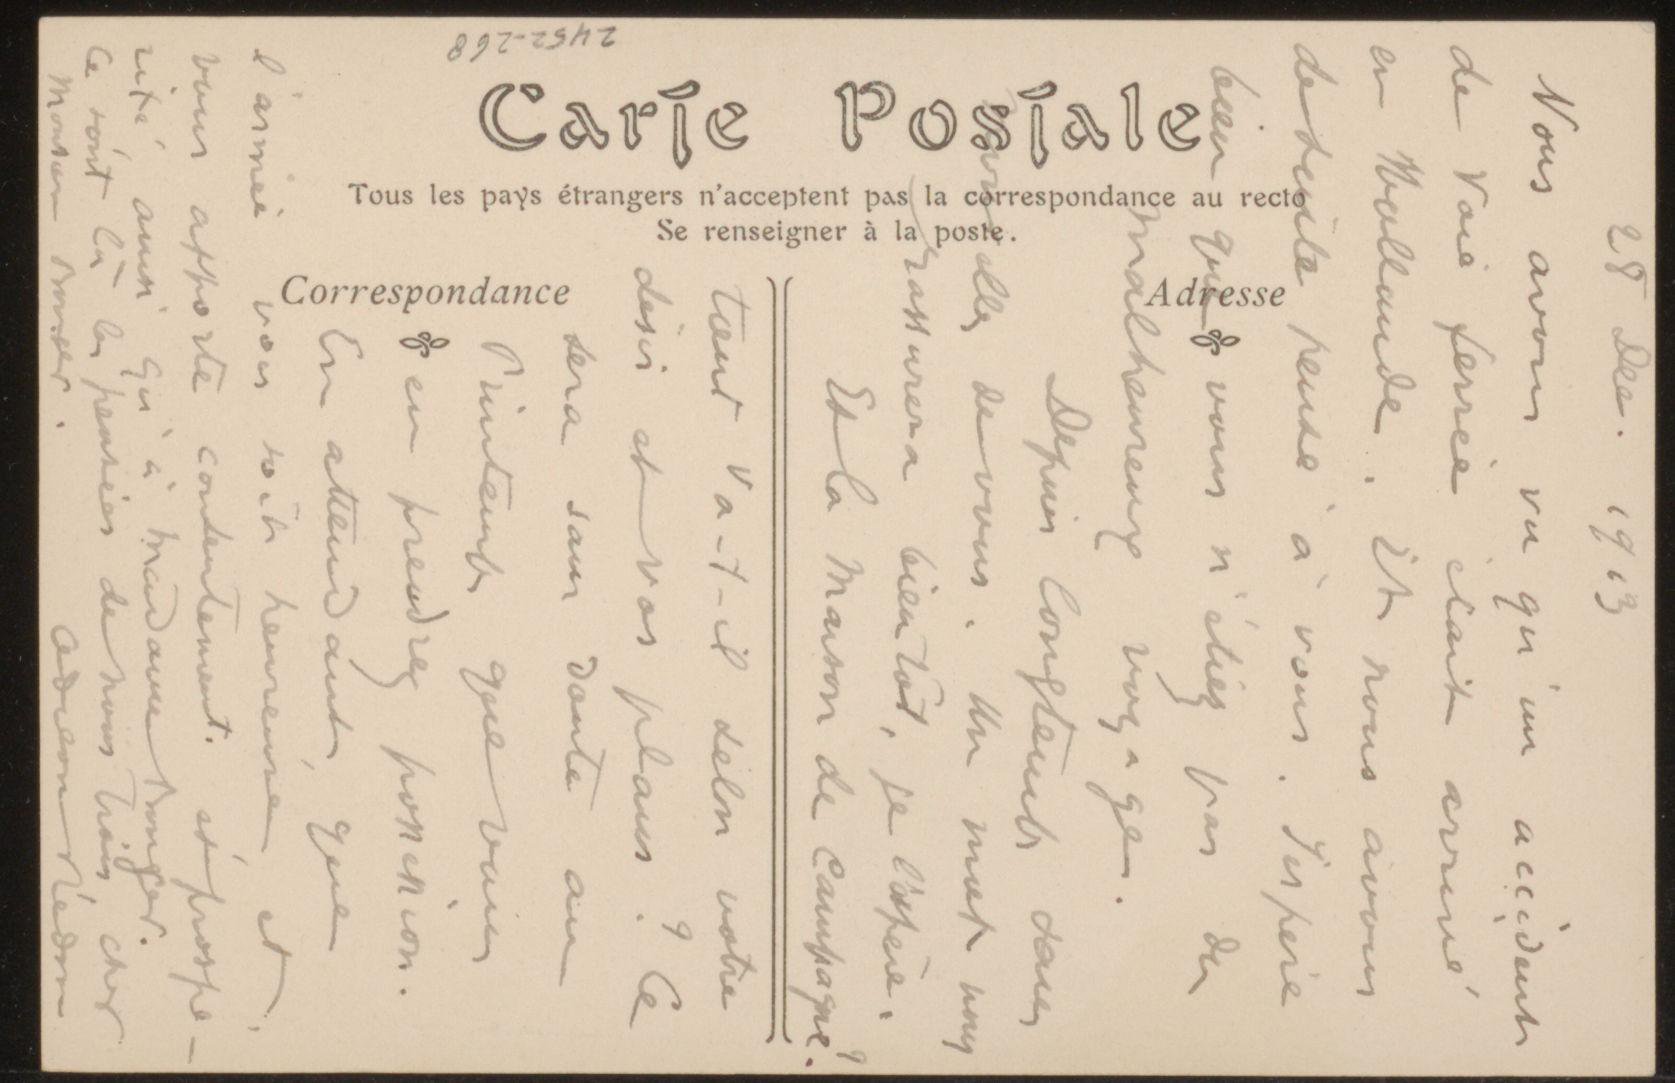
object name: ansichtkaart, prentbriefkaart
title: Prentbriefkaart aan Andries Bonger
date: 1913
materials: cardboard, ink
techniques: photograph, pen, writing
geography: paris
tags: amsterdam, andries bonger